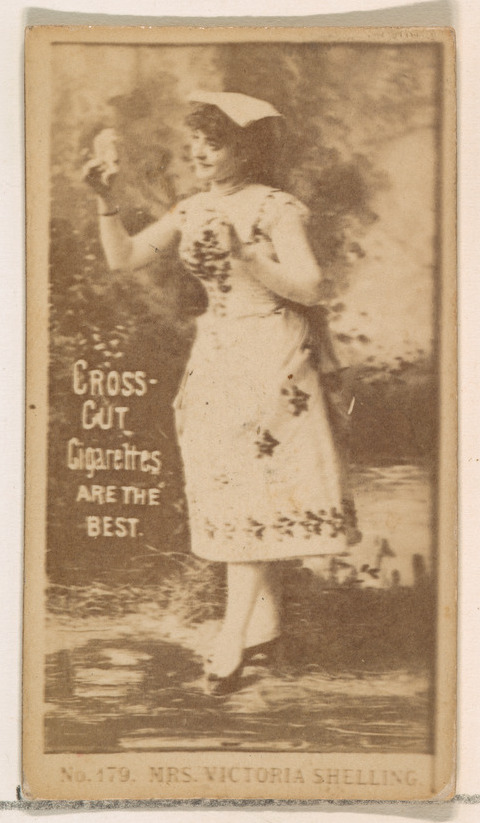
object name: print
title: Card Number 179, Mrs. Victoria Shelling, from the Actors and Actresses series (N145-2) issued by Duke Sons & Co. to promote Cross Cut Cigarettes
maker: w. duke, sons & co.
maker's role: publisher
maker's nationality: american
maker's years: 1870-1920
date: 1880-1889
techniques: albumen silver print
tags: women,actresses